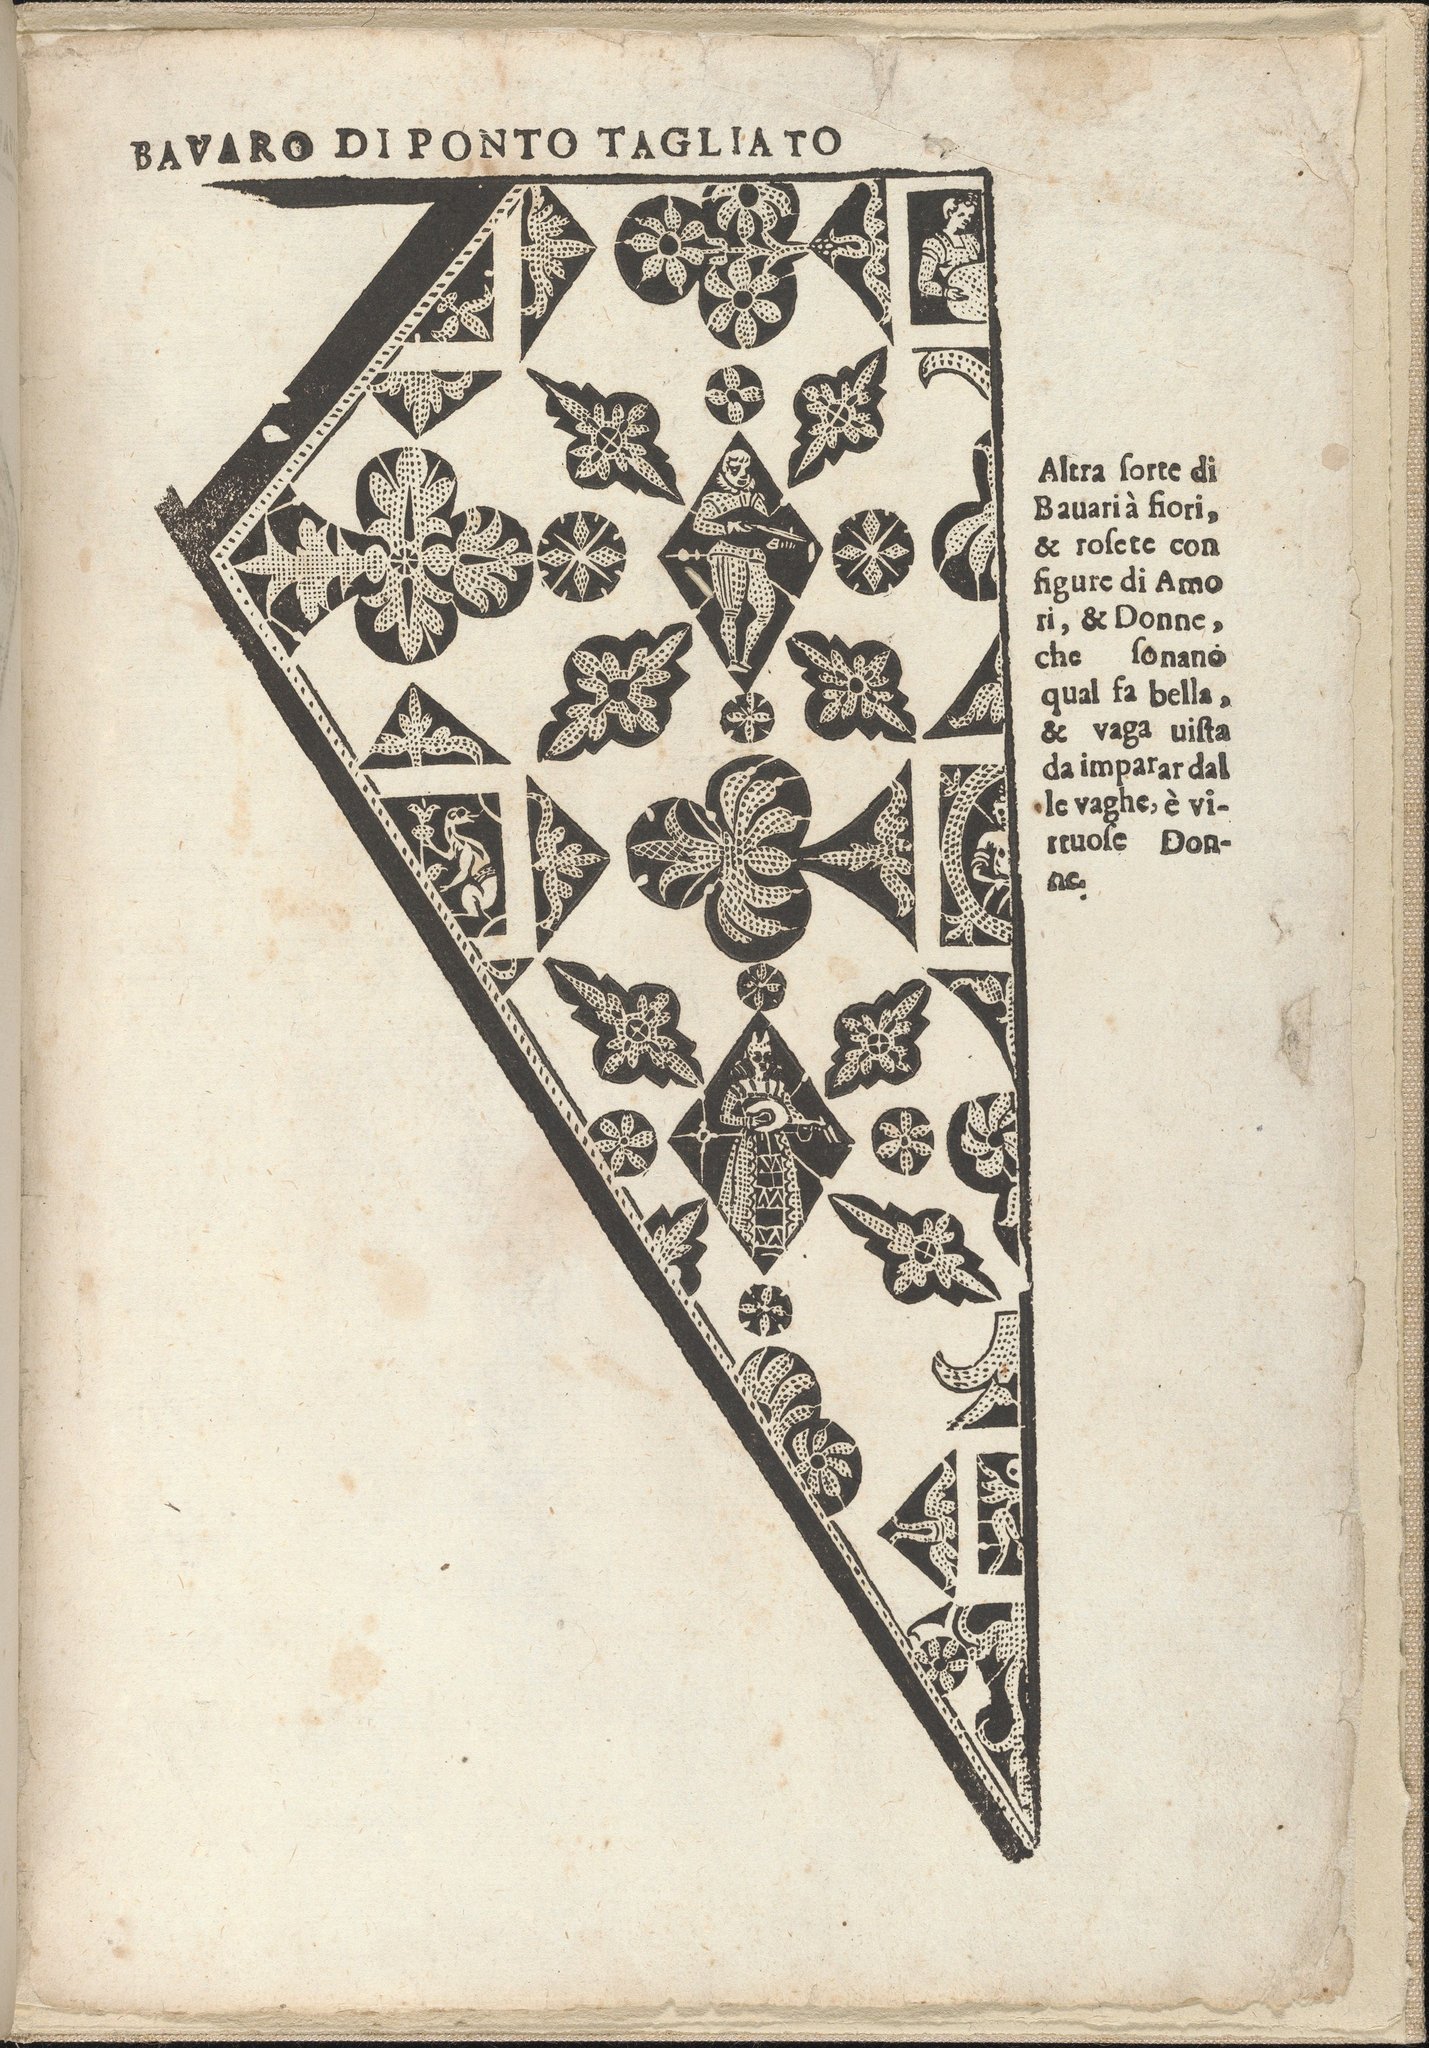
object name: book print ornament architecture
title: Ornamento nobile...Fatta da Lucretia Romana (Libro V of the Corona), page 15 (recto)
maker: cesare vecellio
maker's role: author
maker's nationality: italian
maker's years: 1521-1601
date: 1620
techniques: woodcut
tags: ornament